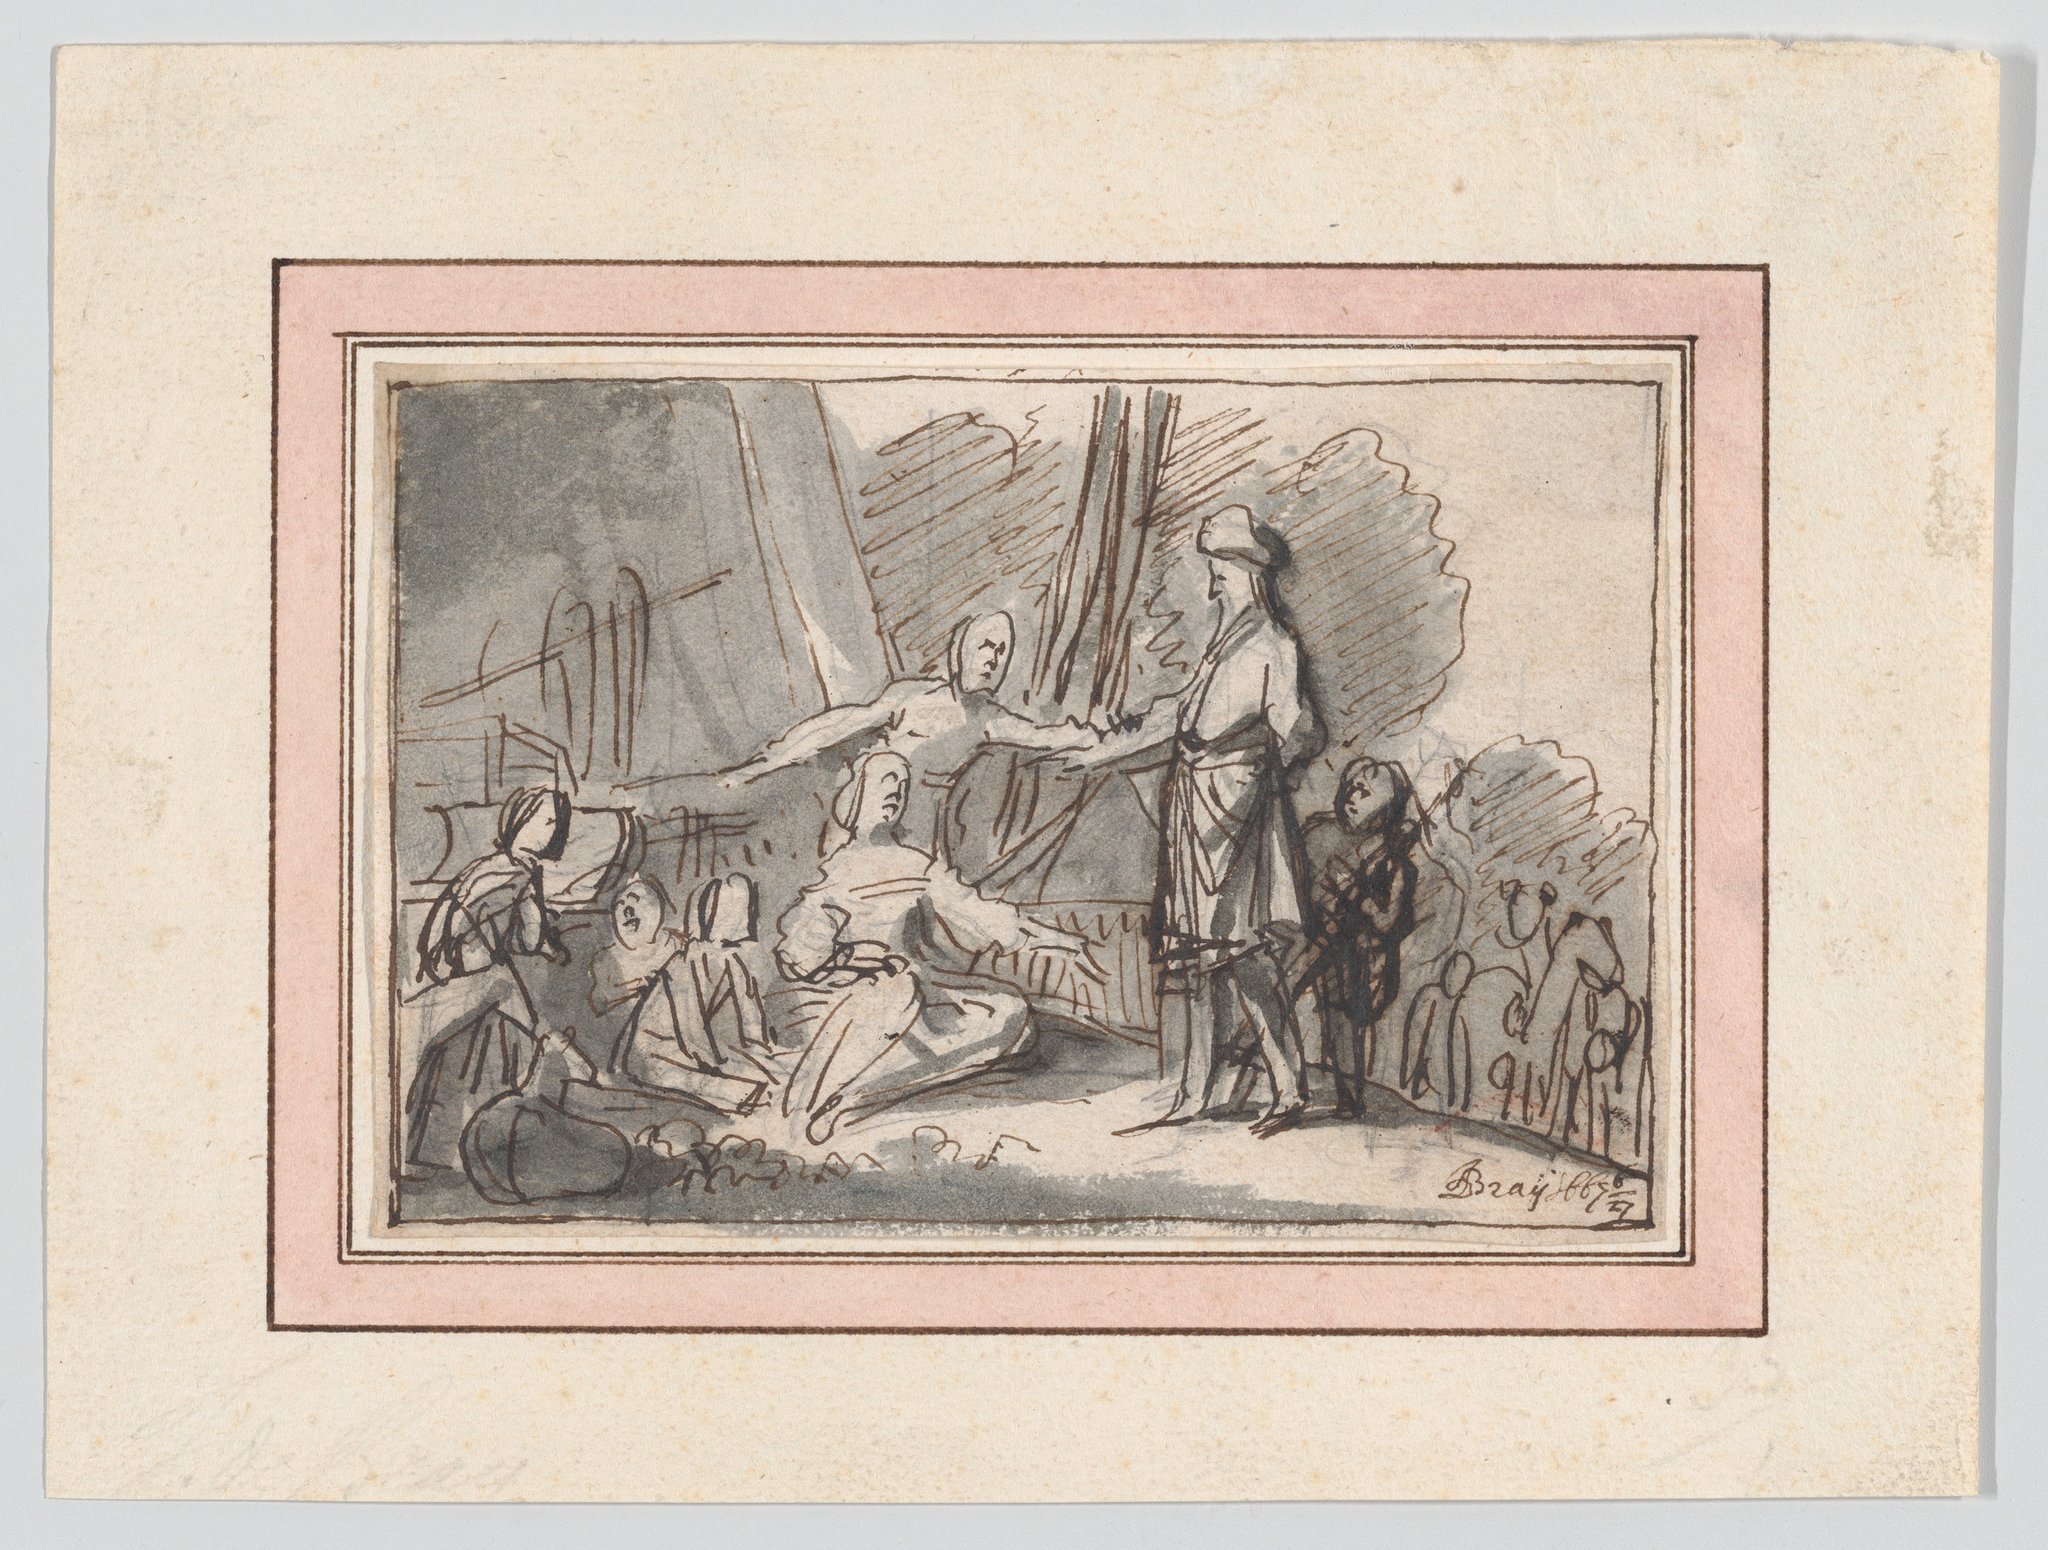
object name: drawing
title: Laban Searching for his Idols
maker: jan de bray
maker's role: artist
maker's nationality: dutch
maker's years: 1622-1697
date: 1667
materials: chalk, ink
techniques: brush, pen, wash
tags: men,women